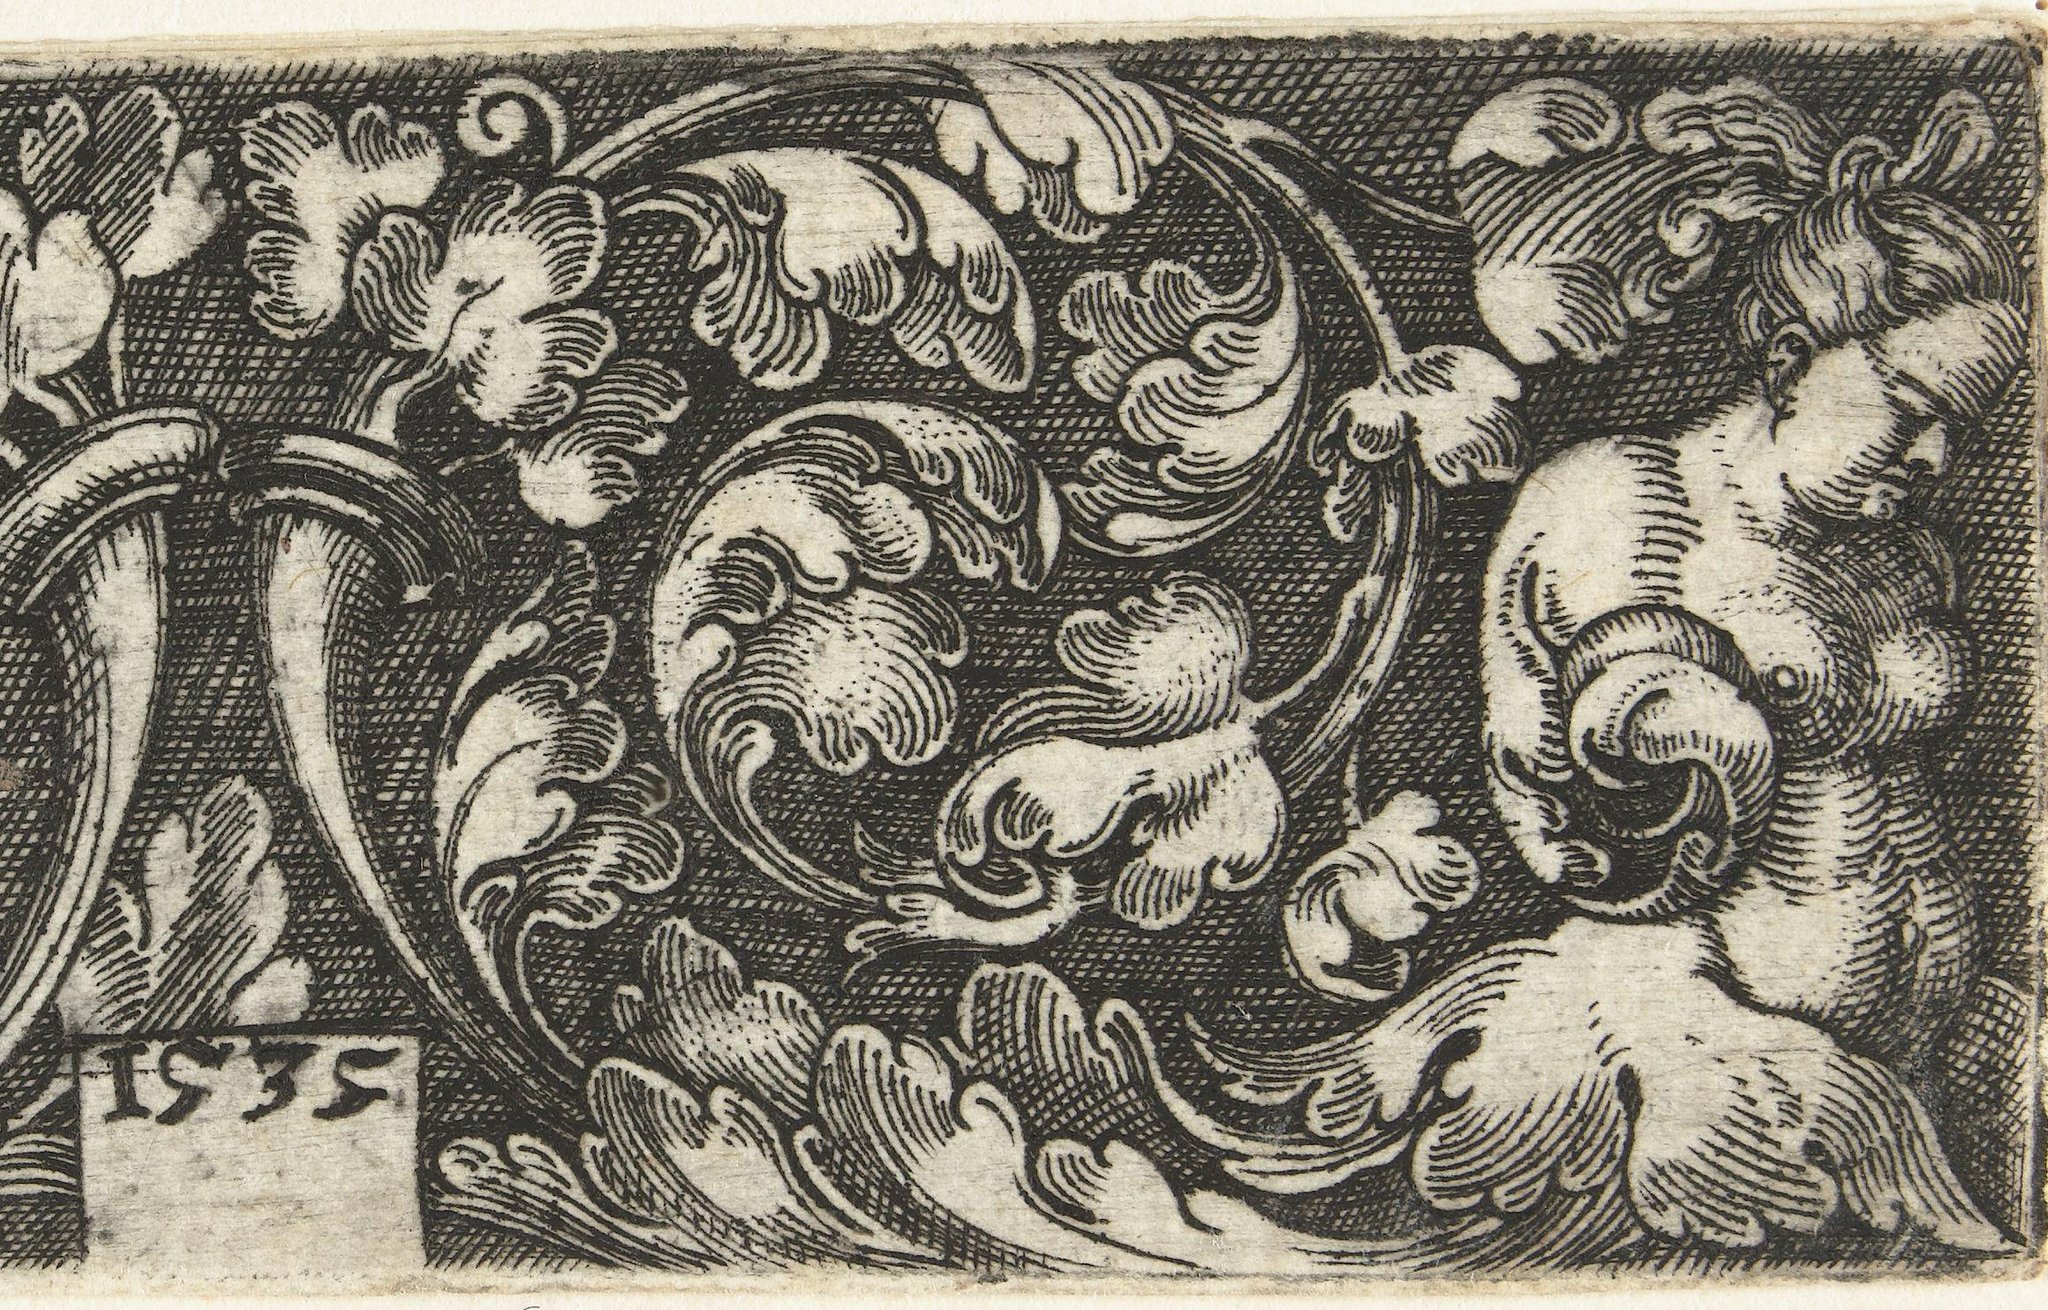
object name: print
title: Fries met links en rechts het bovenlichaam van een vrouw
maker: Anonymous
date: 1500-1535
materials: paper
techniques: engraving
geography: germany